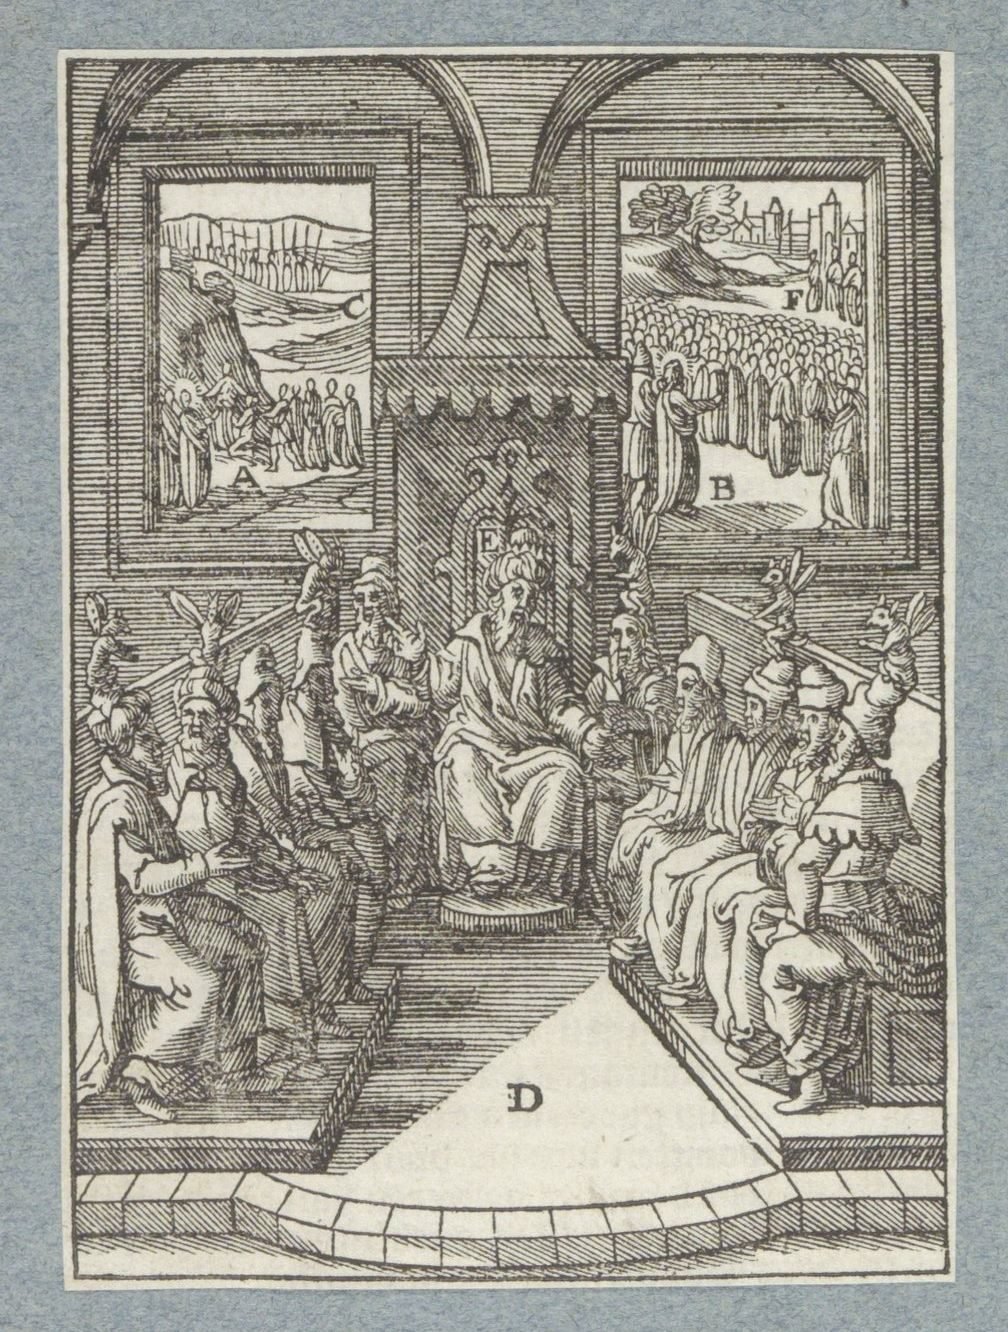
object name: print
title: Vergadering van het Sanhedrin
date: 1629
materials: paper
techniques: letterpress printing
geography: antwerp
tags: caiaphas and the priests conspiring against christ (matthew 26:3-5; mark 14:1-2; luke 22:2; john 11:47-53)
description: De hogepriester Kajafas, onder een baldakijn, en de rest van het Sanhedrin, met duivels boven het hoofd, overleggen over hoe ze Christus zullen doden. Bij verschillende elementen uit de voorstelling staan letters. Op de achtergrond links de Opwekking van Lazarus. Rechts luistert een grote menigte naar de woorden van Christus. De prent maakt deel uit van een album.